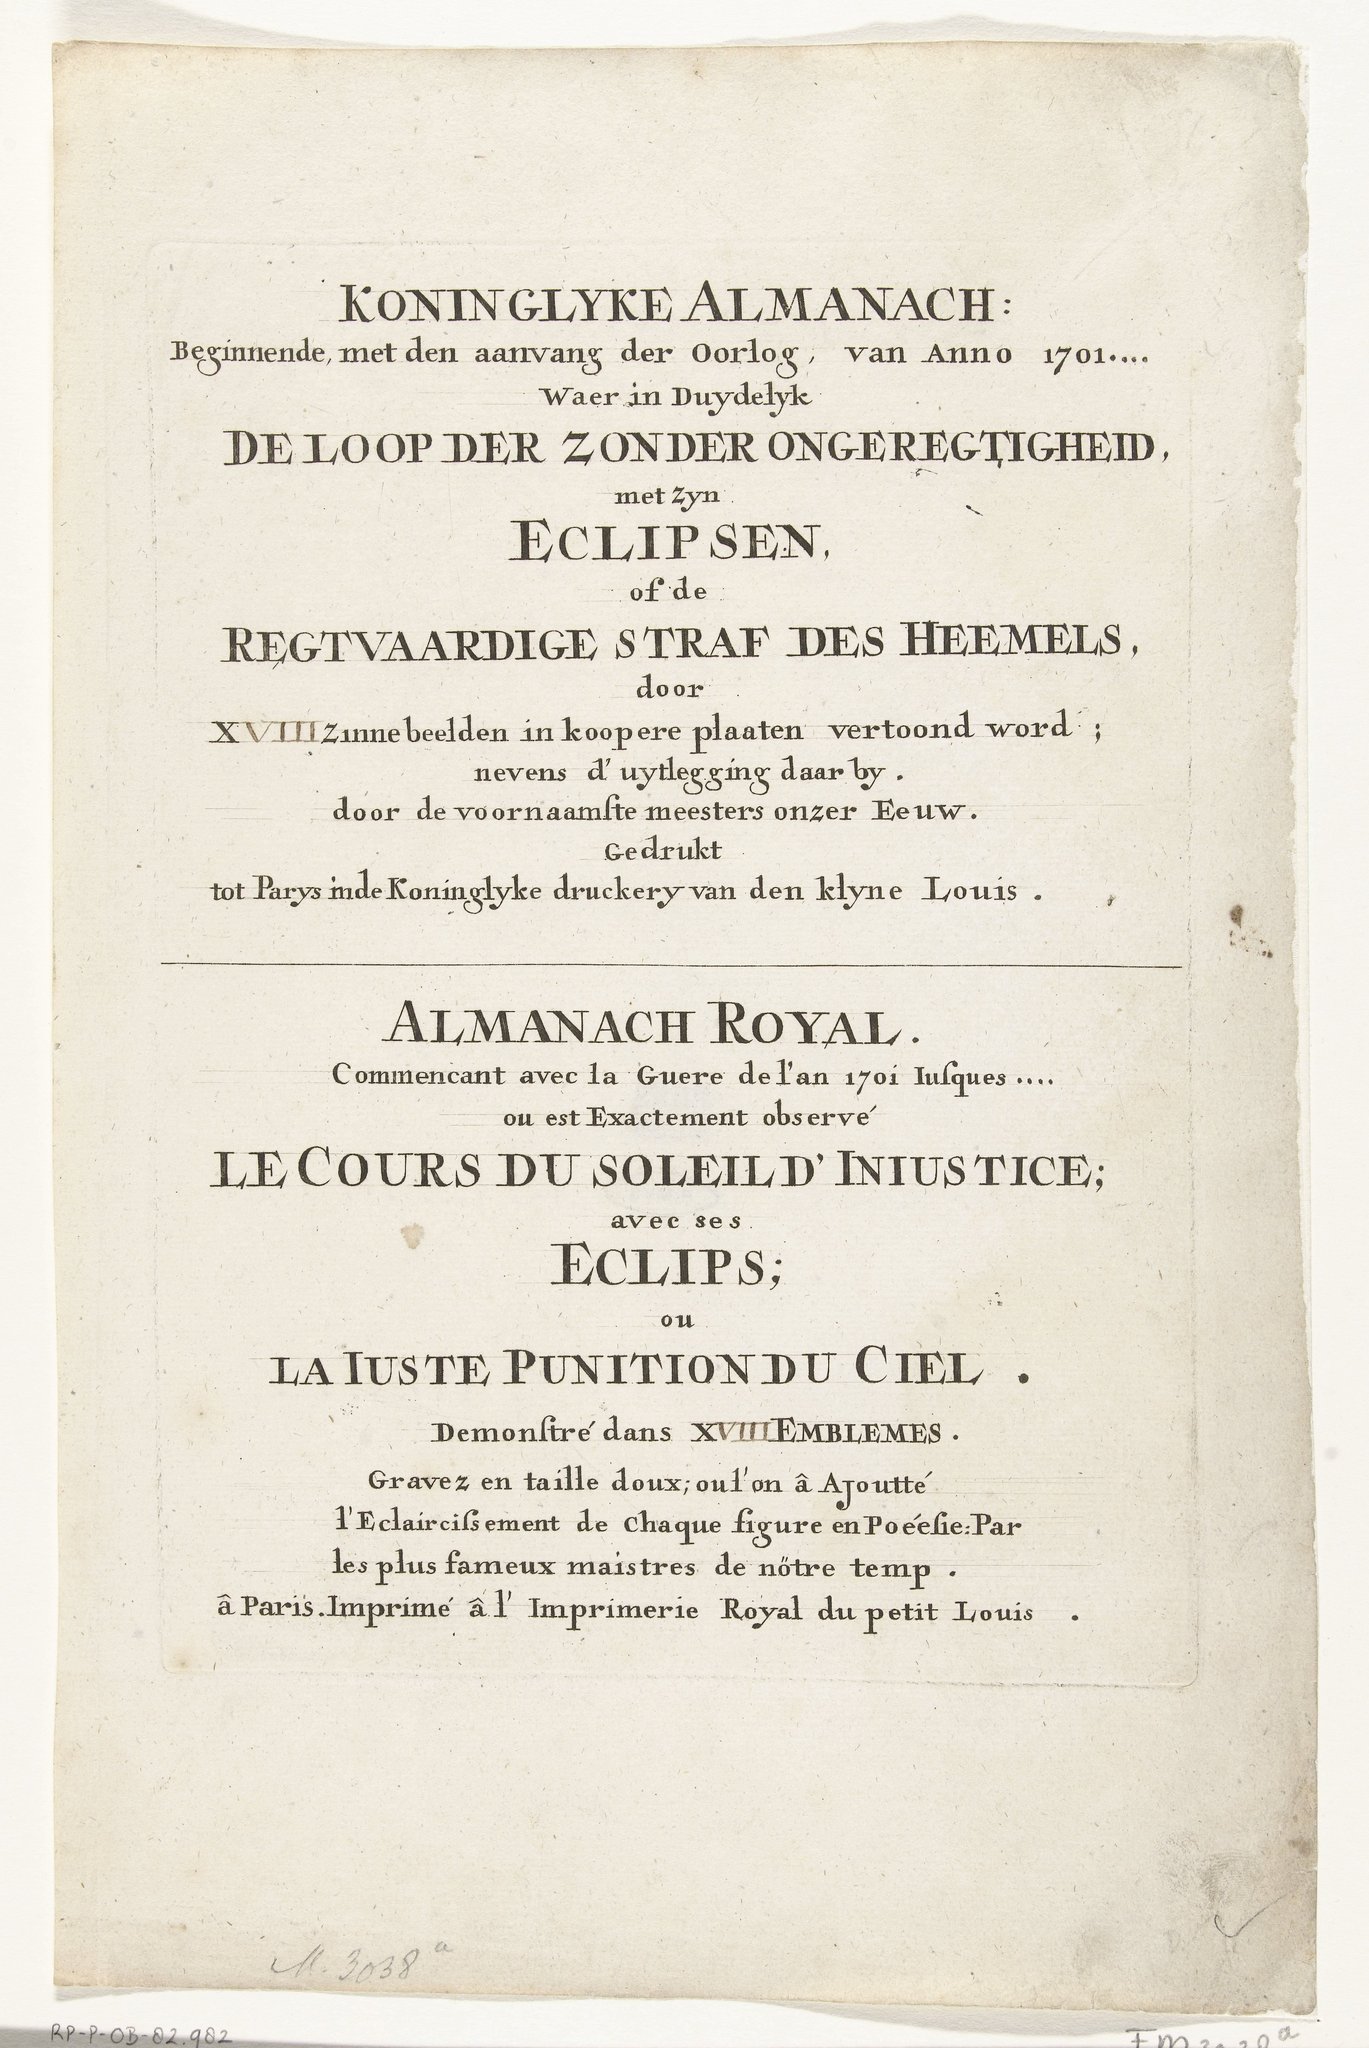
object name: print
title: Almanach Royal. Commencant avec la Guere de l'an 1701 (...)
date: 1706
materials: paper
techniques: engraving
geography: northern netherlands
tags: lodewijk xiv (koning van frankrijk)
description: Gegraveerde titelprent voor de Koninklijke Almanach van 1701 met de twee titels in het Nederlands en Frans. Titel voor een reeks van 19 spotprenten op de Fransen en bondgenoten uit het jaar 1706.